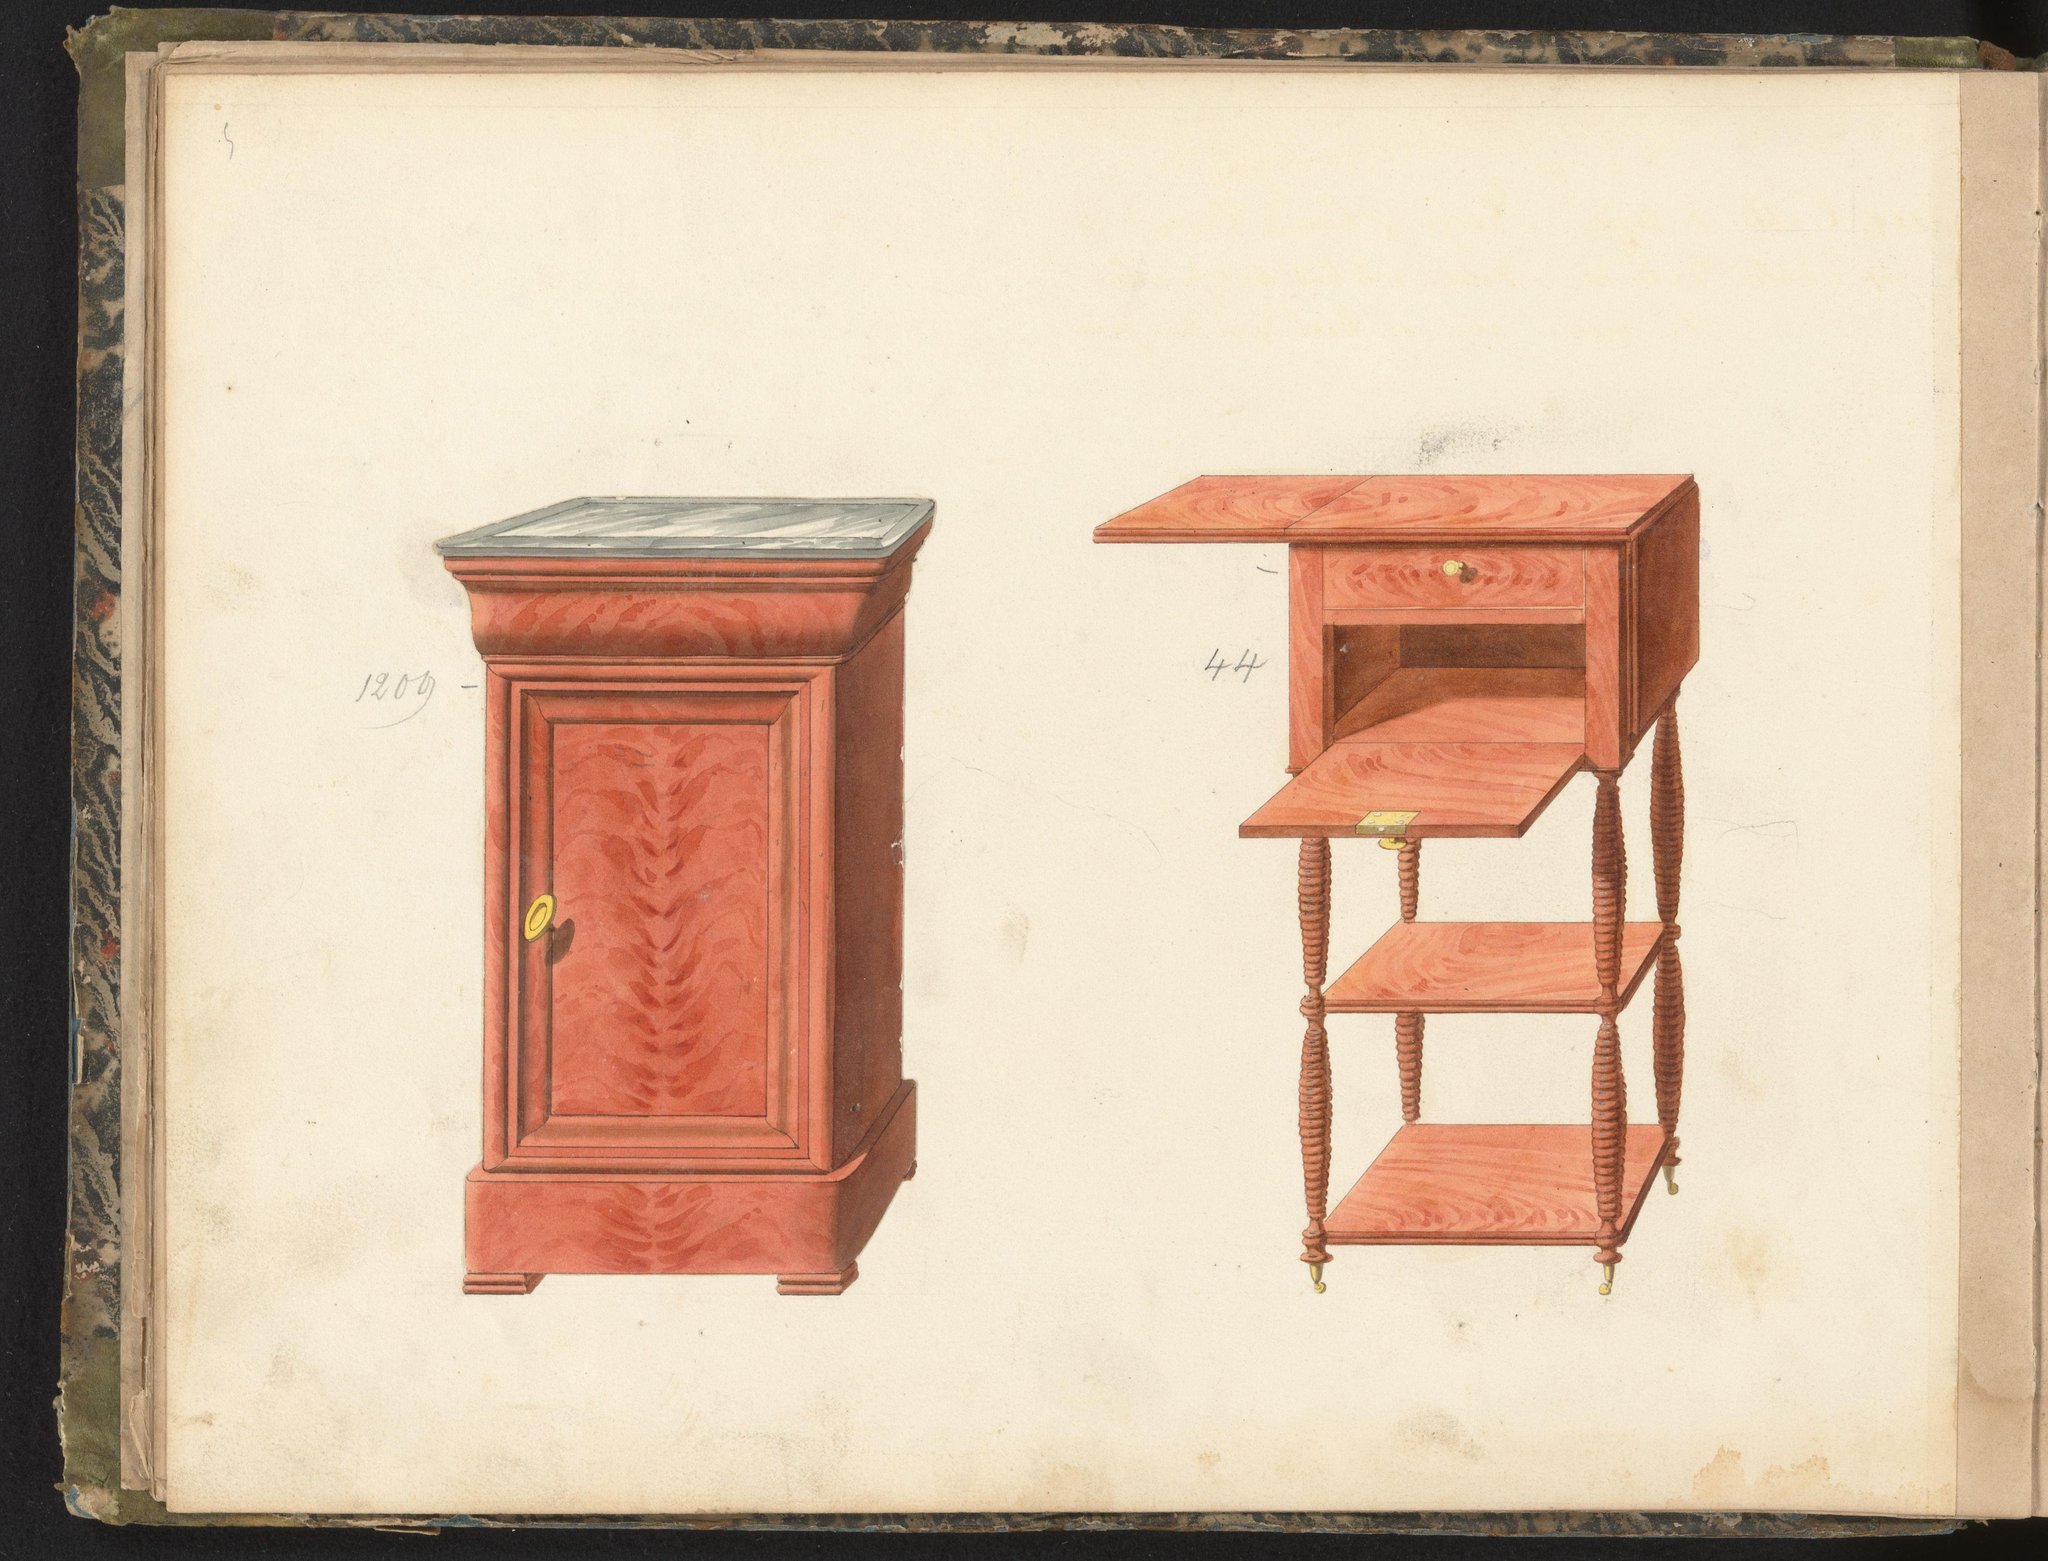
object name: album leaf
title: Twee ontwerpen voor nachtkastjes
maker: Anonymous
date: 1825-1839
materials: ink, paper, pencil, watercolor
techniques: brush, pen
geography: paris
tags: furniture for special use (+ wood and other phytogenic material), table, cupboard, bedroom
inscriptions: inscription: ‘1209 Table de nuite à gorge & grand cadre 44 Table de nuite à volets à 2 tablette & pies tordes " la même avec une table & un vuidepoche’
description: Twee ontwerpen voor nachtkastjes waarvan één met marmeren blad en een open nachtkastje met gedraaide poten. Het bovenste deel is gesloten met een lade en wangen aan beide kanten. Het blad op de achterzijde genummerd: 5, het tegenoverliggende blad met informatie over de afgebeelde meubelen genummerd: 5 bis. Onderdeel van een album met 80 bladen met tekeningen en een prent van gefineerde en gelakte meubelen, alsmede zitmeubelen.